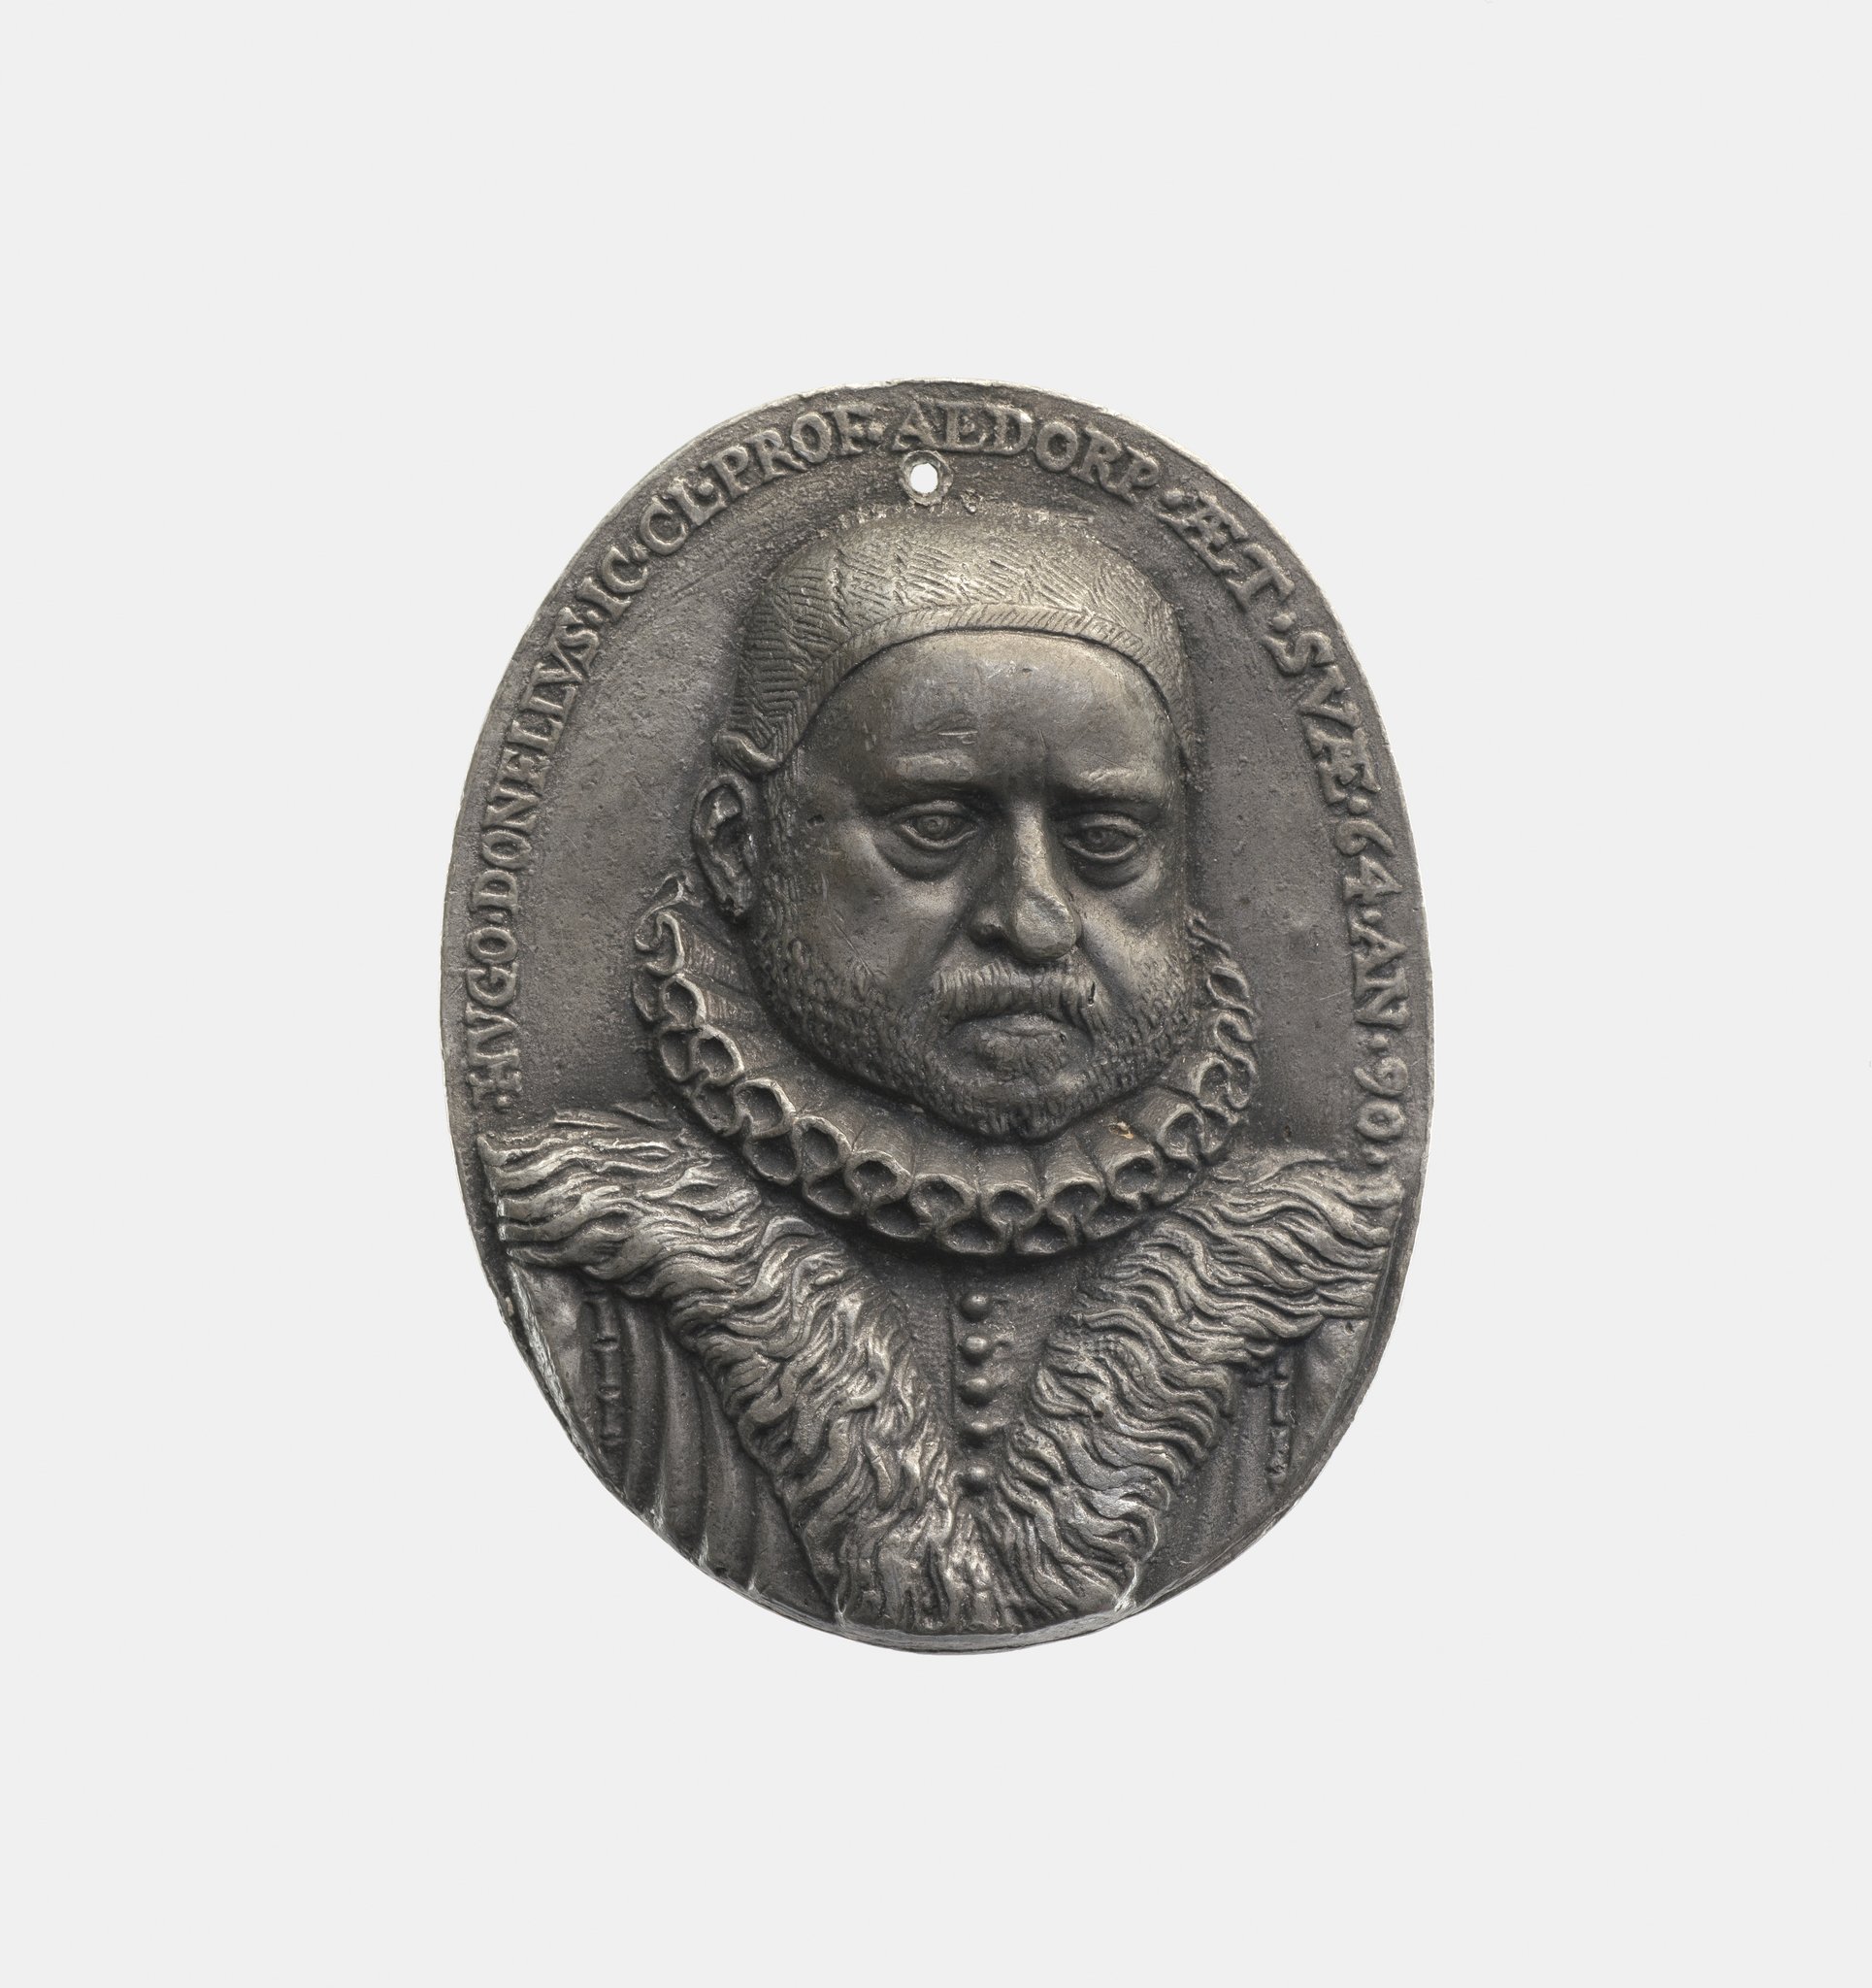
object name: medal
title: Hugo Donellus (Doneau) 1527-91, famed law scholar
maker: georg holdermann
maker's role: artist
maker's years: 1585-1629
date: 1590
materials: lead